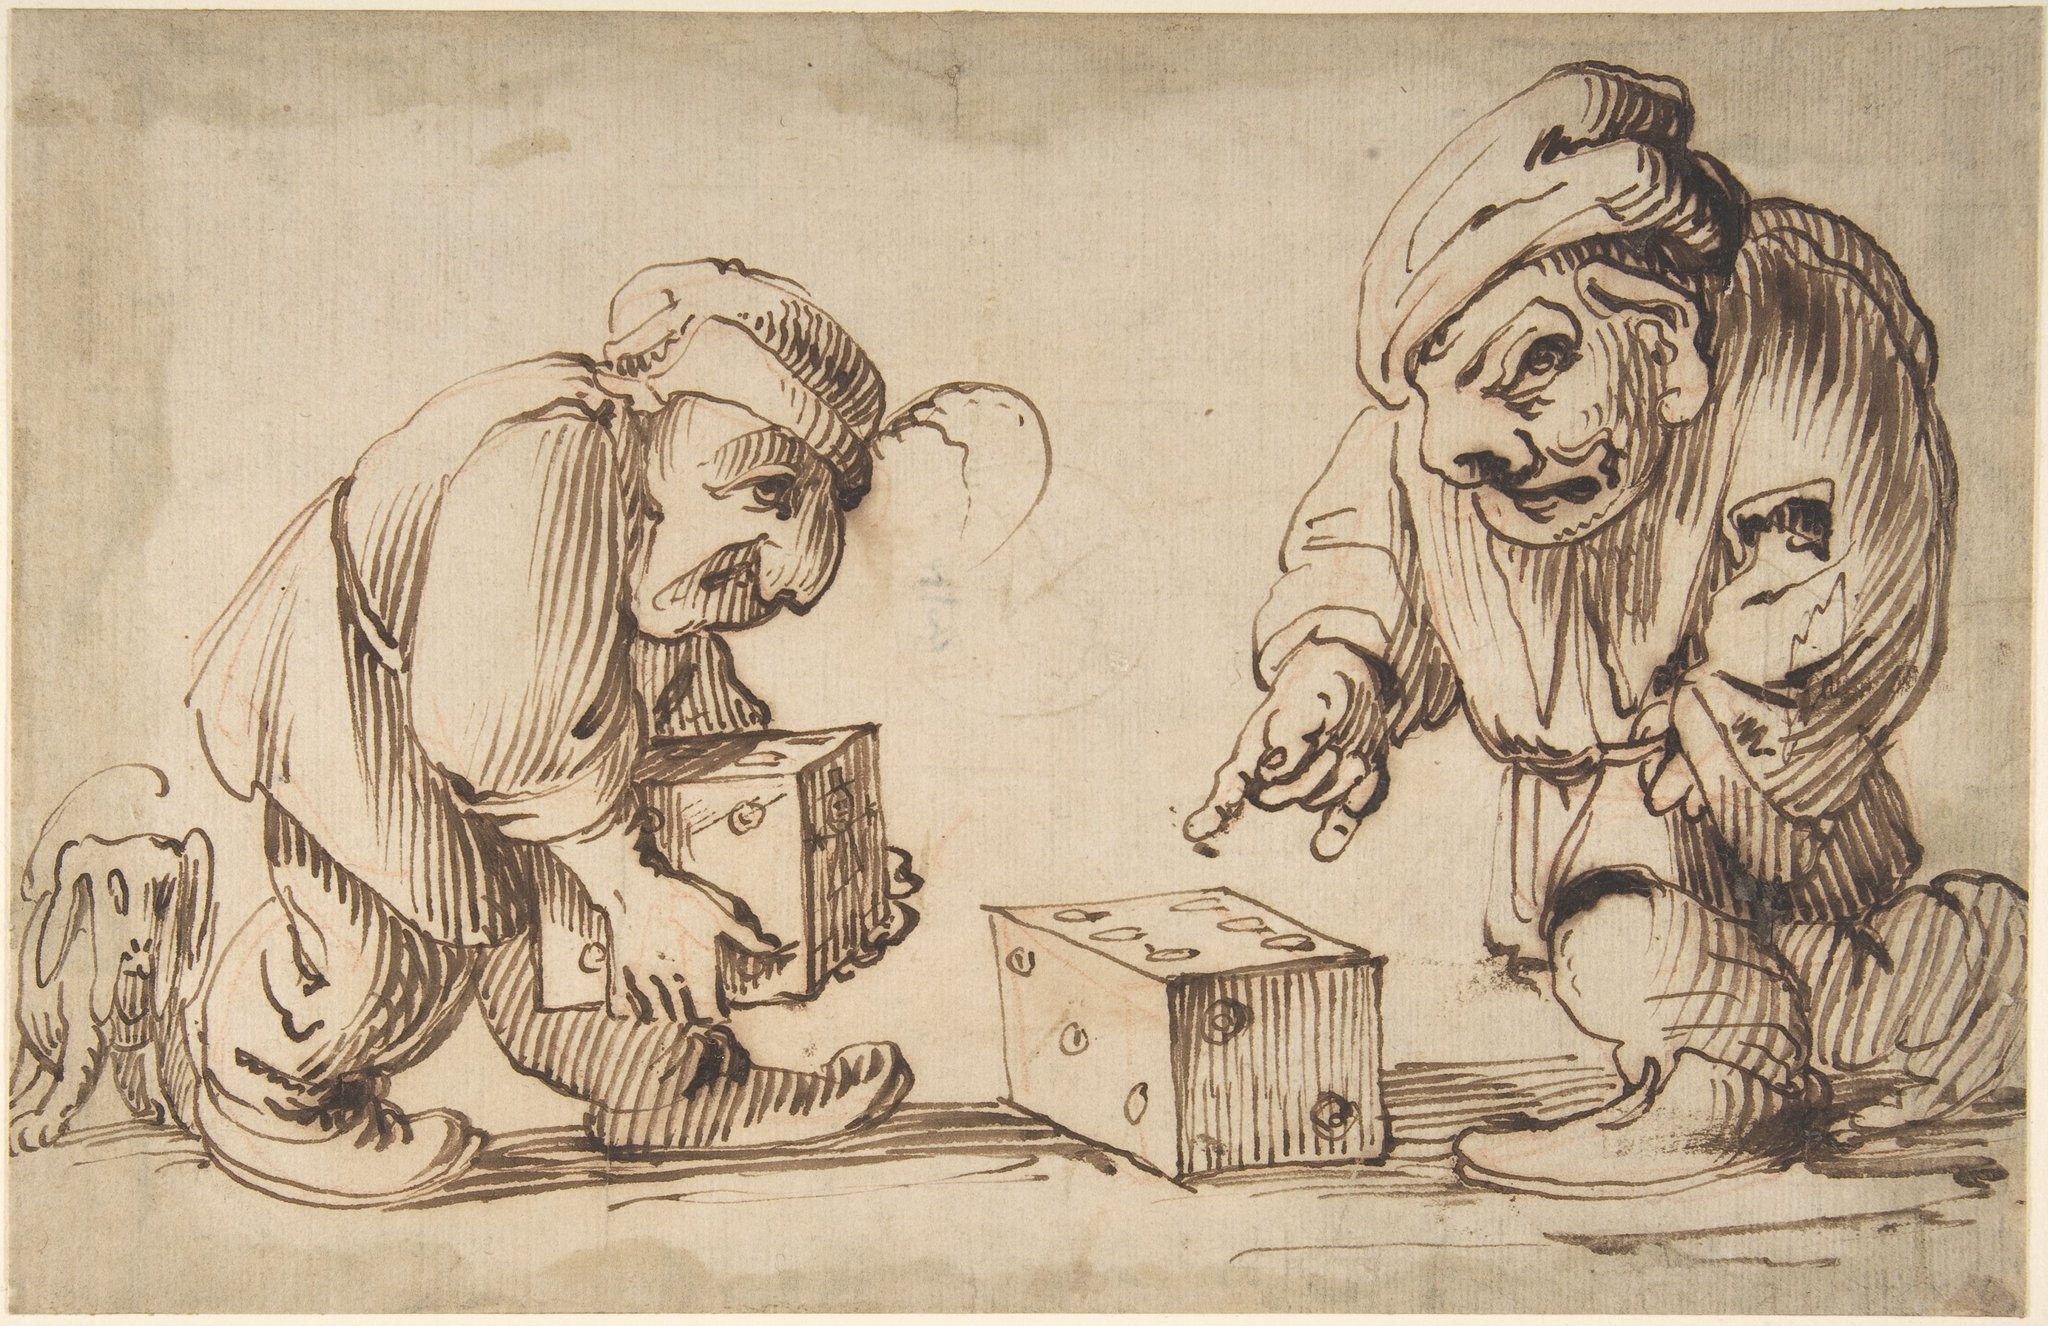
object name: drawing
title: Two Dwarfs Playing Dice, a Dog at Left (recto); Study of a Leg (verso)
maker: faustino bocchi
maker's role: artist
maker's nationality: italian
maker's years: 1659-1741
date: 1659-1742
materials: chalk, ink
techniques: pen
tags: men,dice,dogs